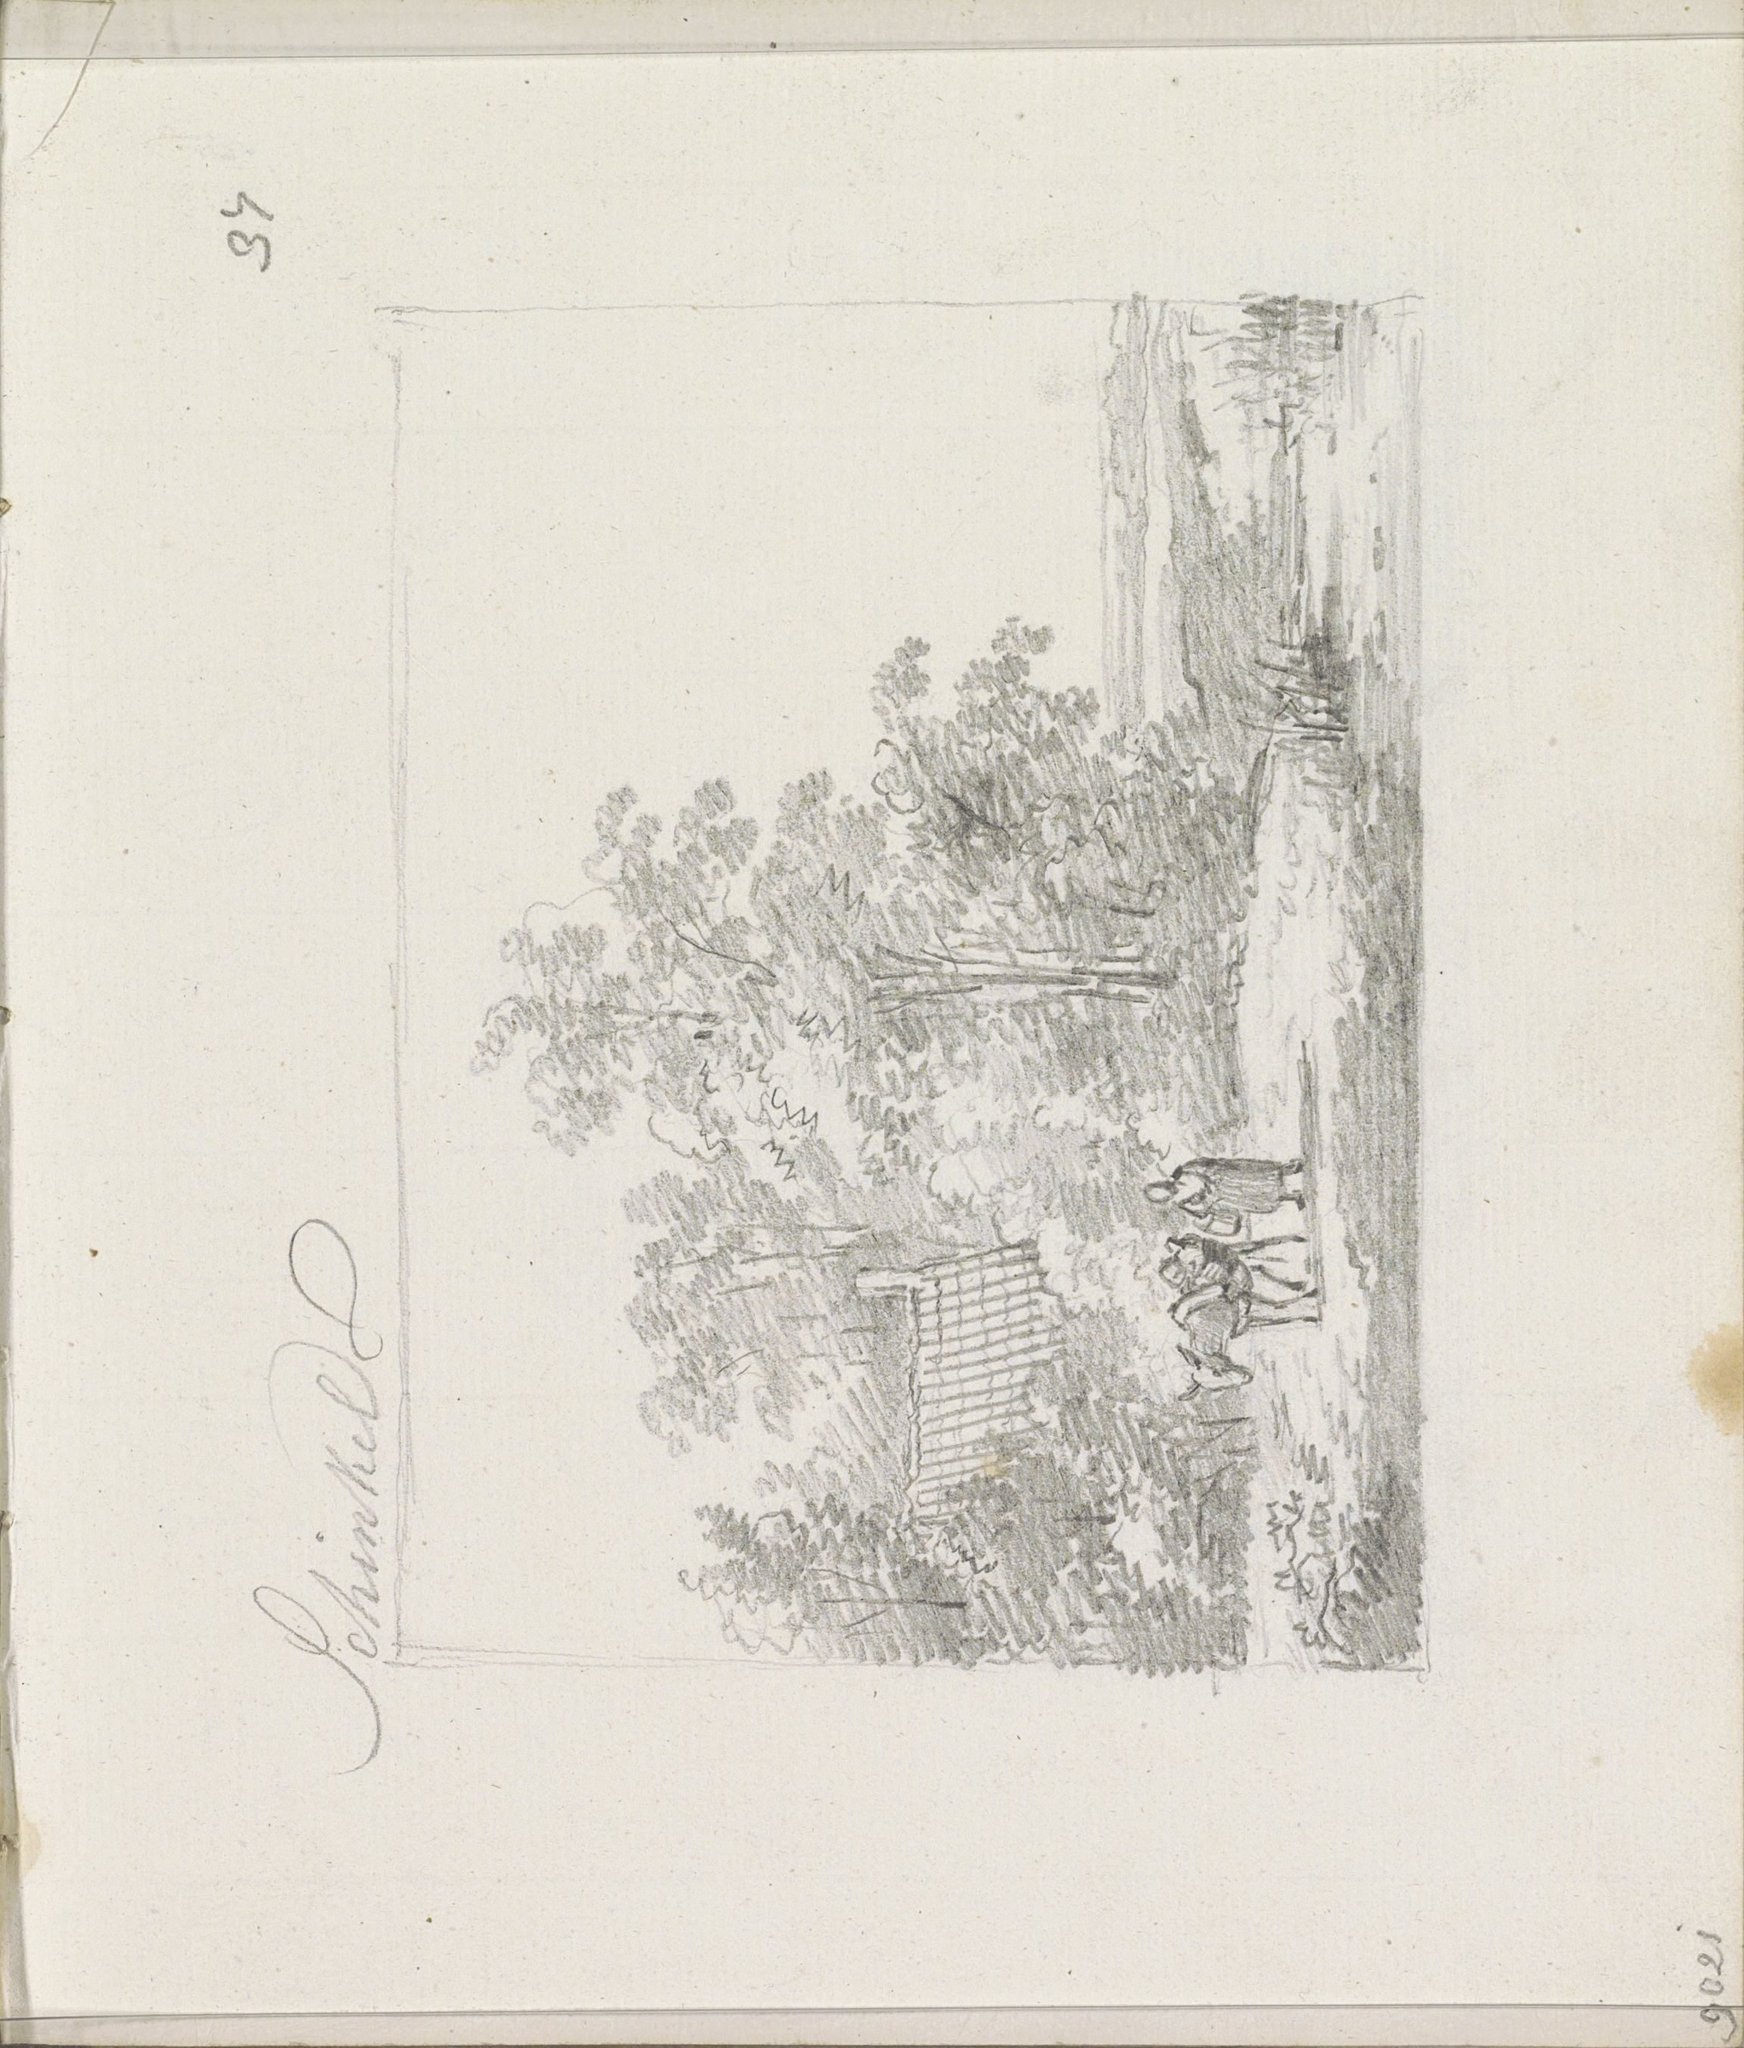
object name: sketchbook leaf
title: Boerin en ezel op een grasveld naast een sloot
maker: andreas schelfhout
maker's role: draughtsman, painter, print maker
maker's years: 1787-1870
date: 1825-1829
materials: paper, pencil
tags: mule, meadow, pasture (+ landscape with figures, staffage)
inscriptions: annotation: ‘Schinkel’, number: ‘37/ 9021’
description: Op de achtergrond het dak van een woning. Blad 51 recto uit een schetsboek met 95 bladen.